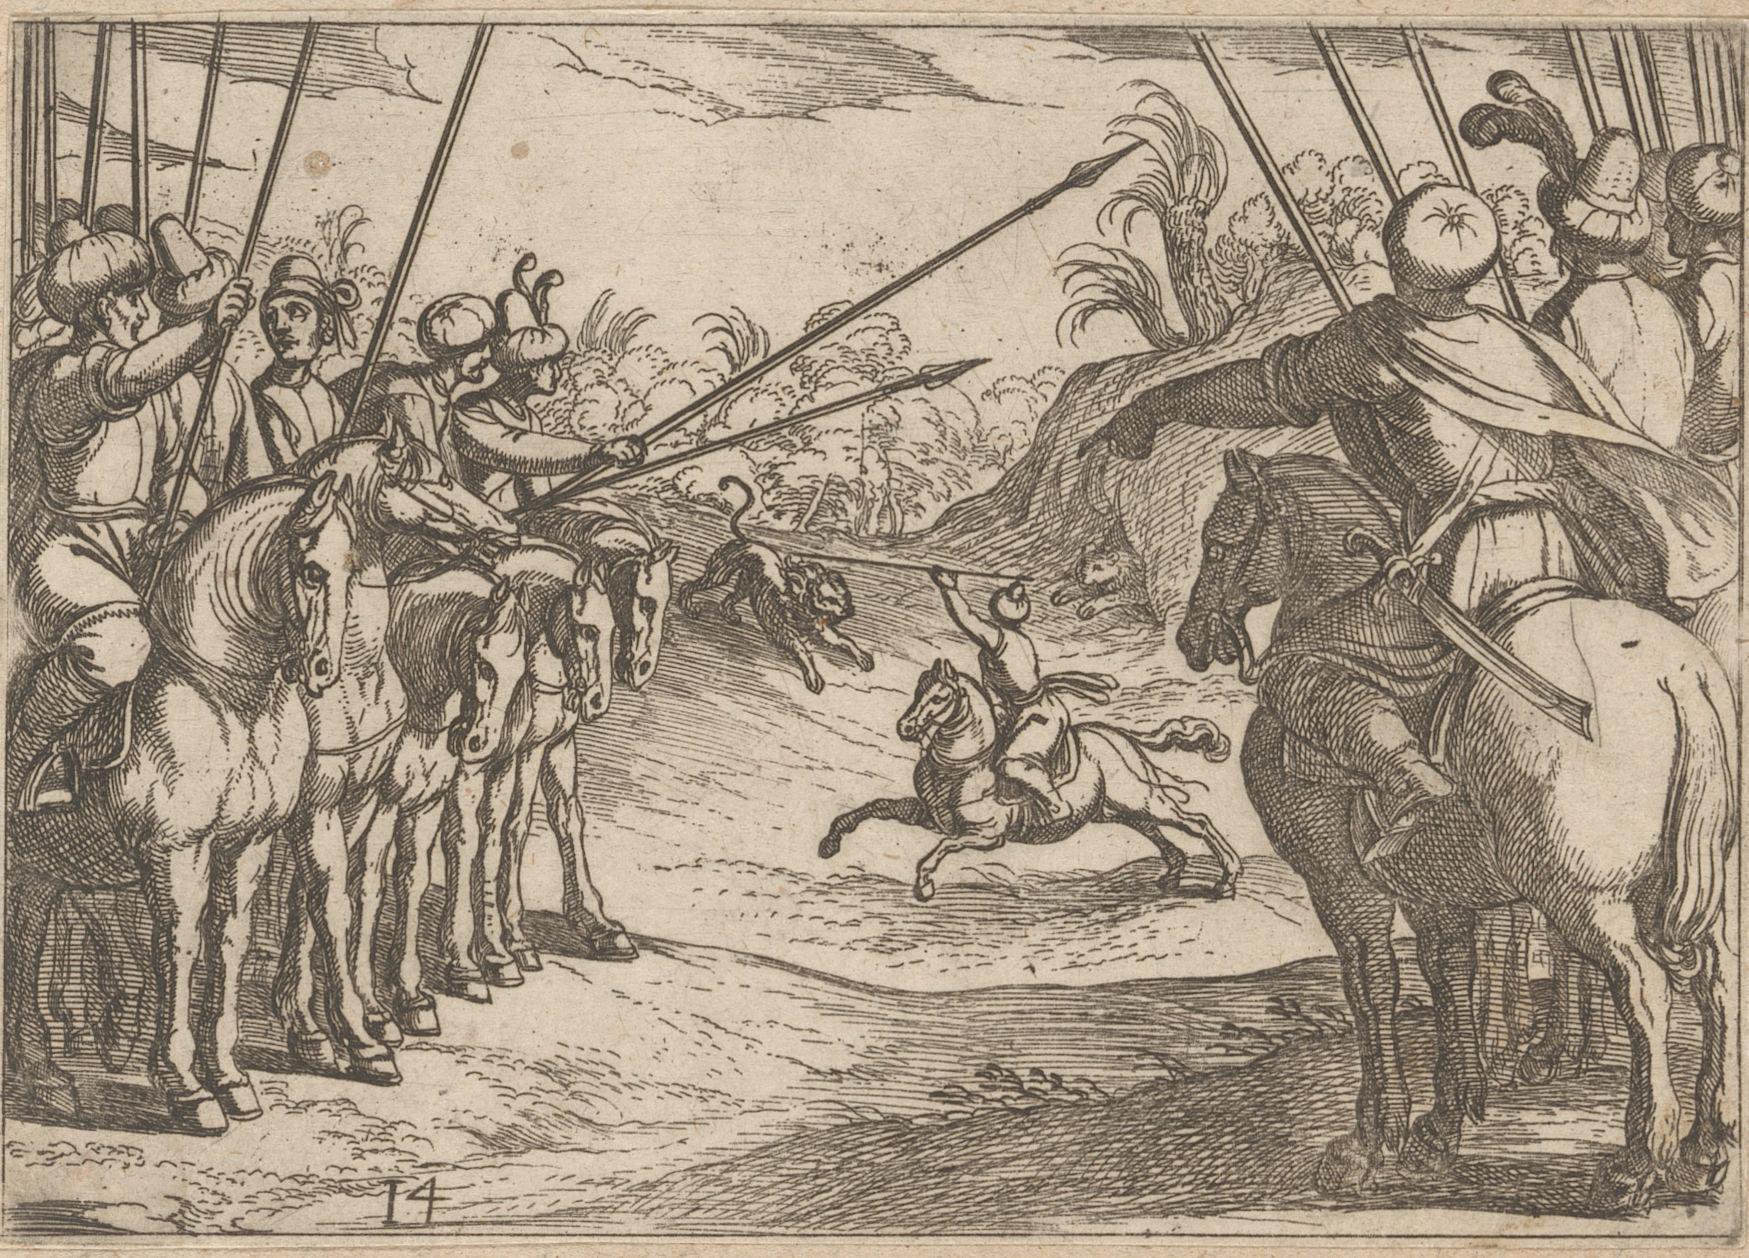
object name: print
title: Jacht op leeuwen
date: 1598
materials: paper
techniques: etching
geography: italy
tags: lion hunt, hunter, hunters hunting (n.b.: in 1988-1990 this notation denoted the concept of 43c11421 'hunters resting during the hunt')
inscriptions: collector's mark: Lugt 11, collector's mark: ‘Hinloopen’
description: Deze prent maakt deel uit van een reeks van vijftien prenten met jachtscènes (+ opdracht).